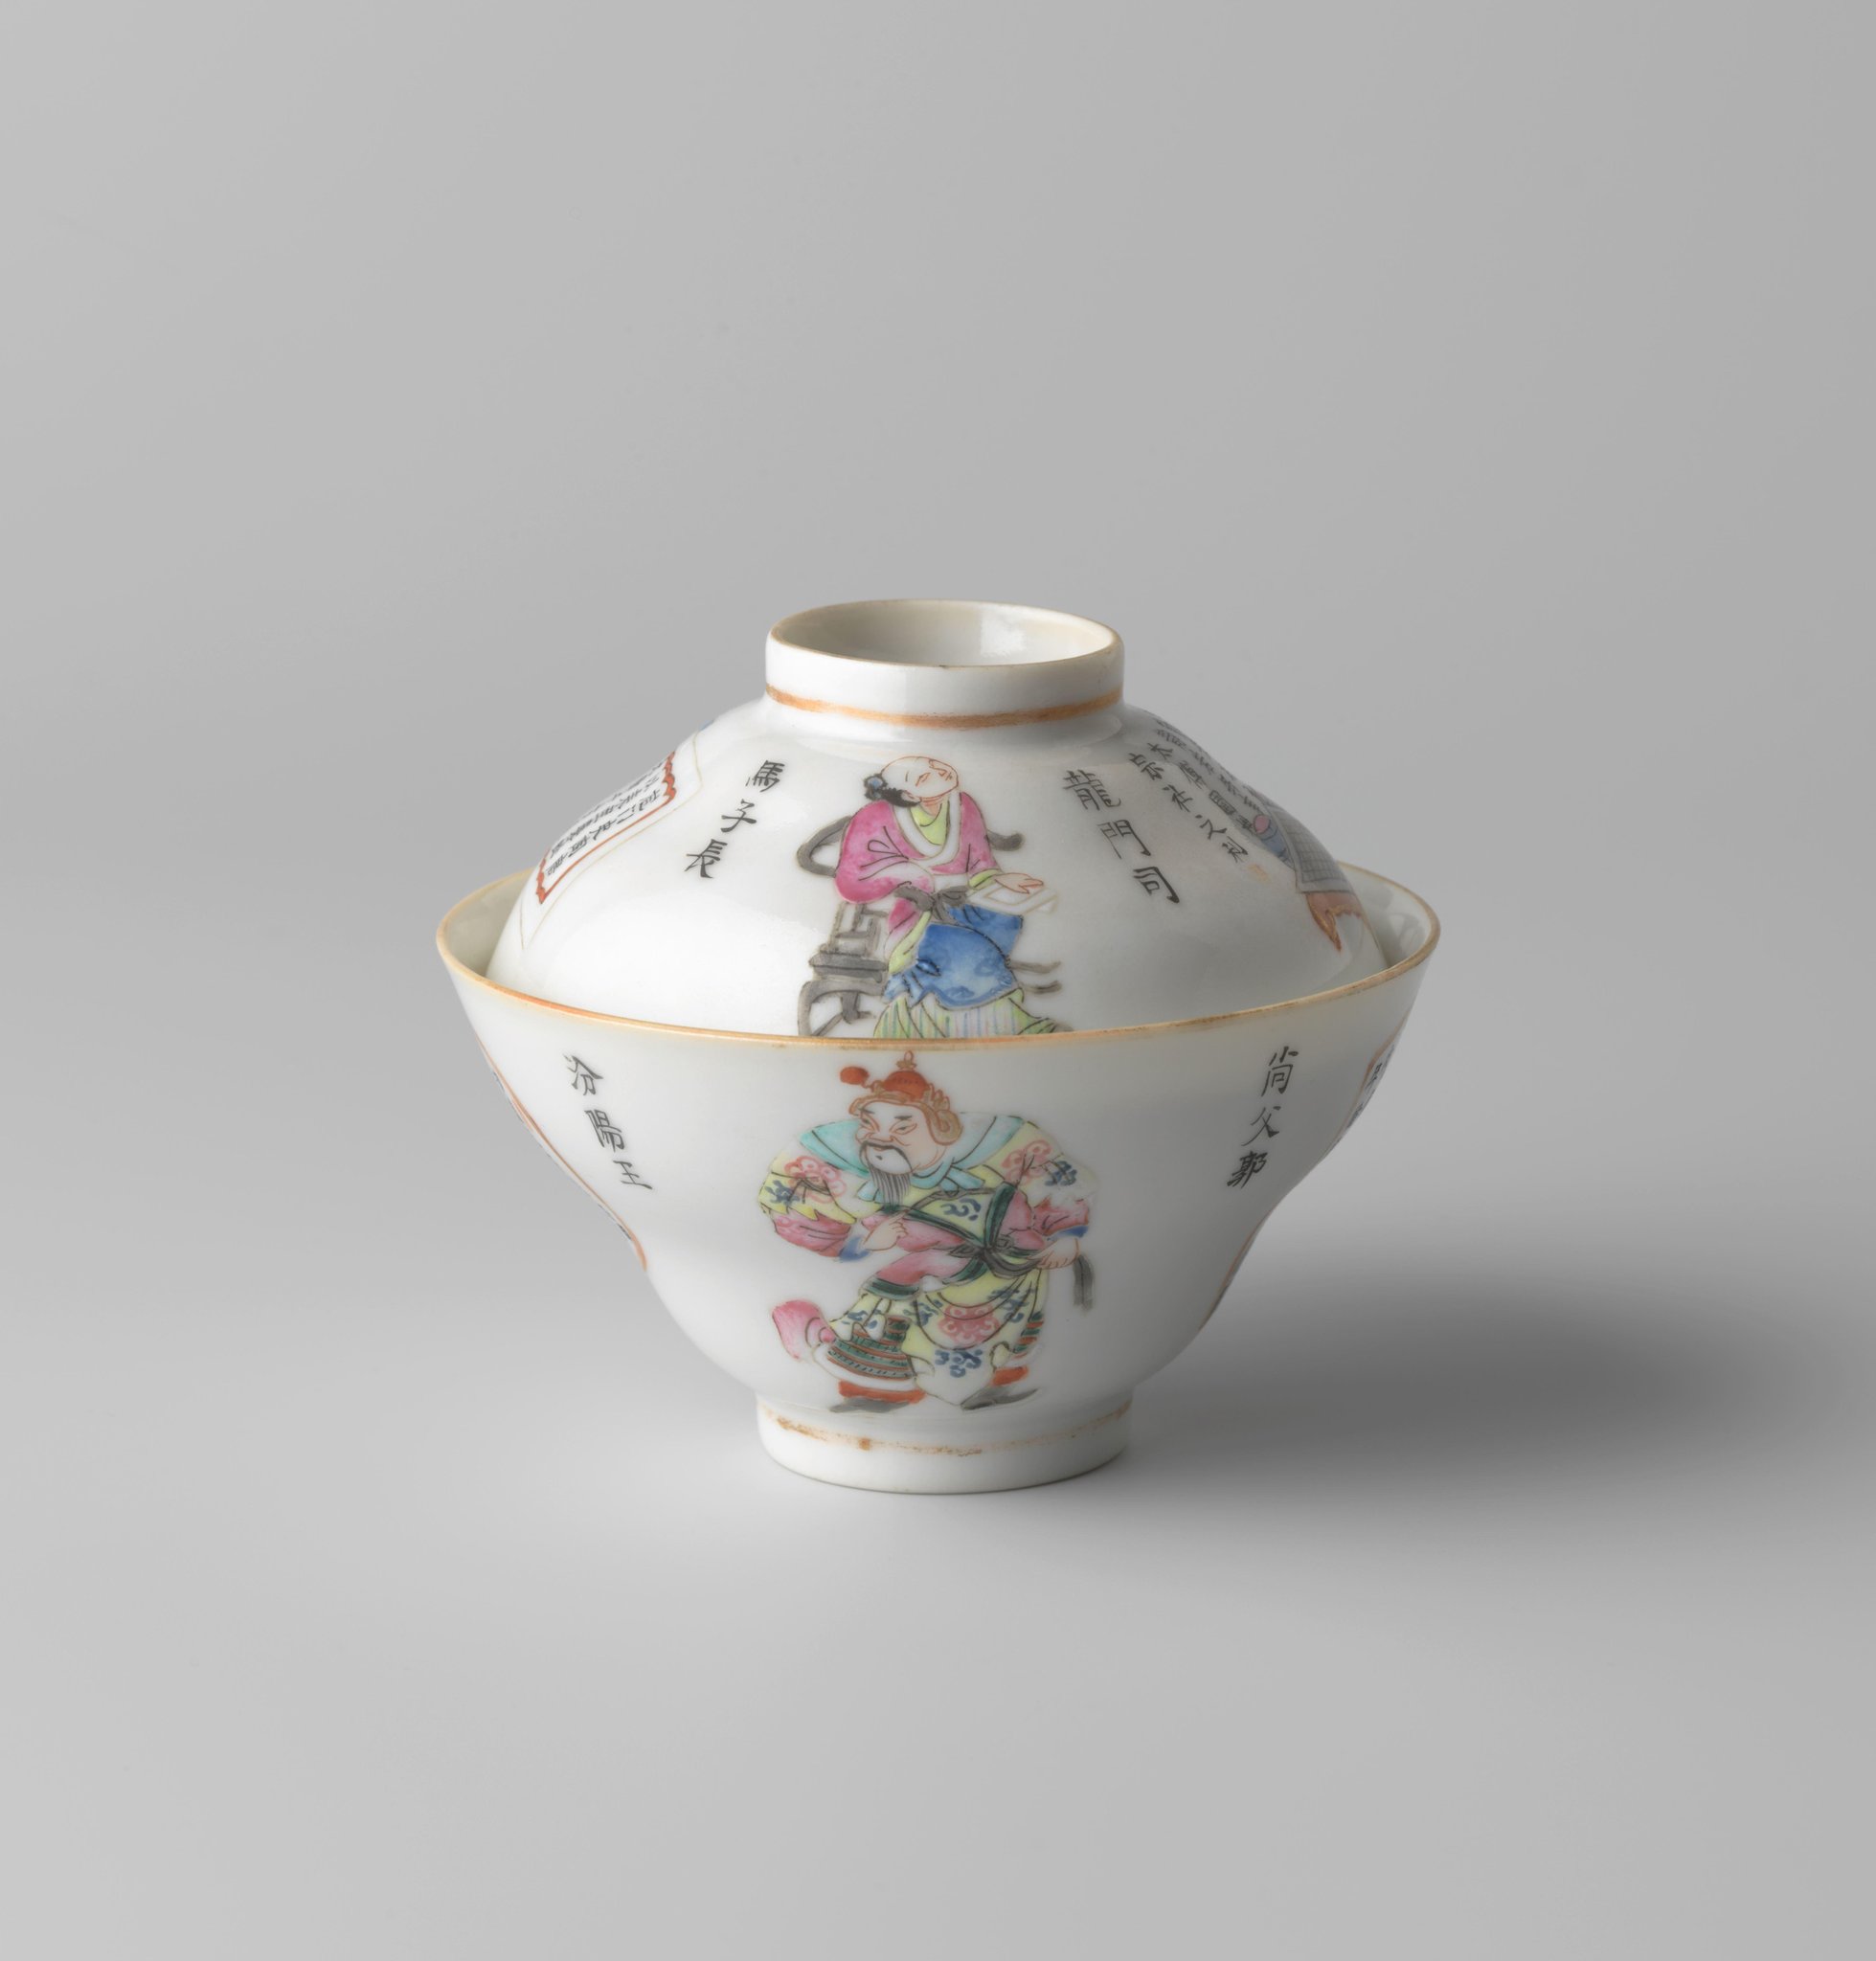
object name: cup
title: Covered cup with Chinese figures and inscriptions in panels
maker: Anonymous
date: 1800-1899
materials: glaze, gold, paint, porcelain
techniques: firing, gilding, turning, vitrification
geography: china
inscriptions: mark: ‘大 清 道 光 年 製’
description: Dekselkop van porselein met een getrapte wand, beschilderd op het glazuur in blauw, rood, roze, groen, geel, zwart en goud. Op het buitenwand van de kop twee krijgers met aan weerszijden Chinese karakters; hiertussen twee cartouches met opschriften. De kop gemerkt met het zegelmerk van keizer Daoguang (?). Famille rose.